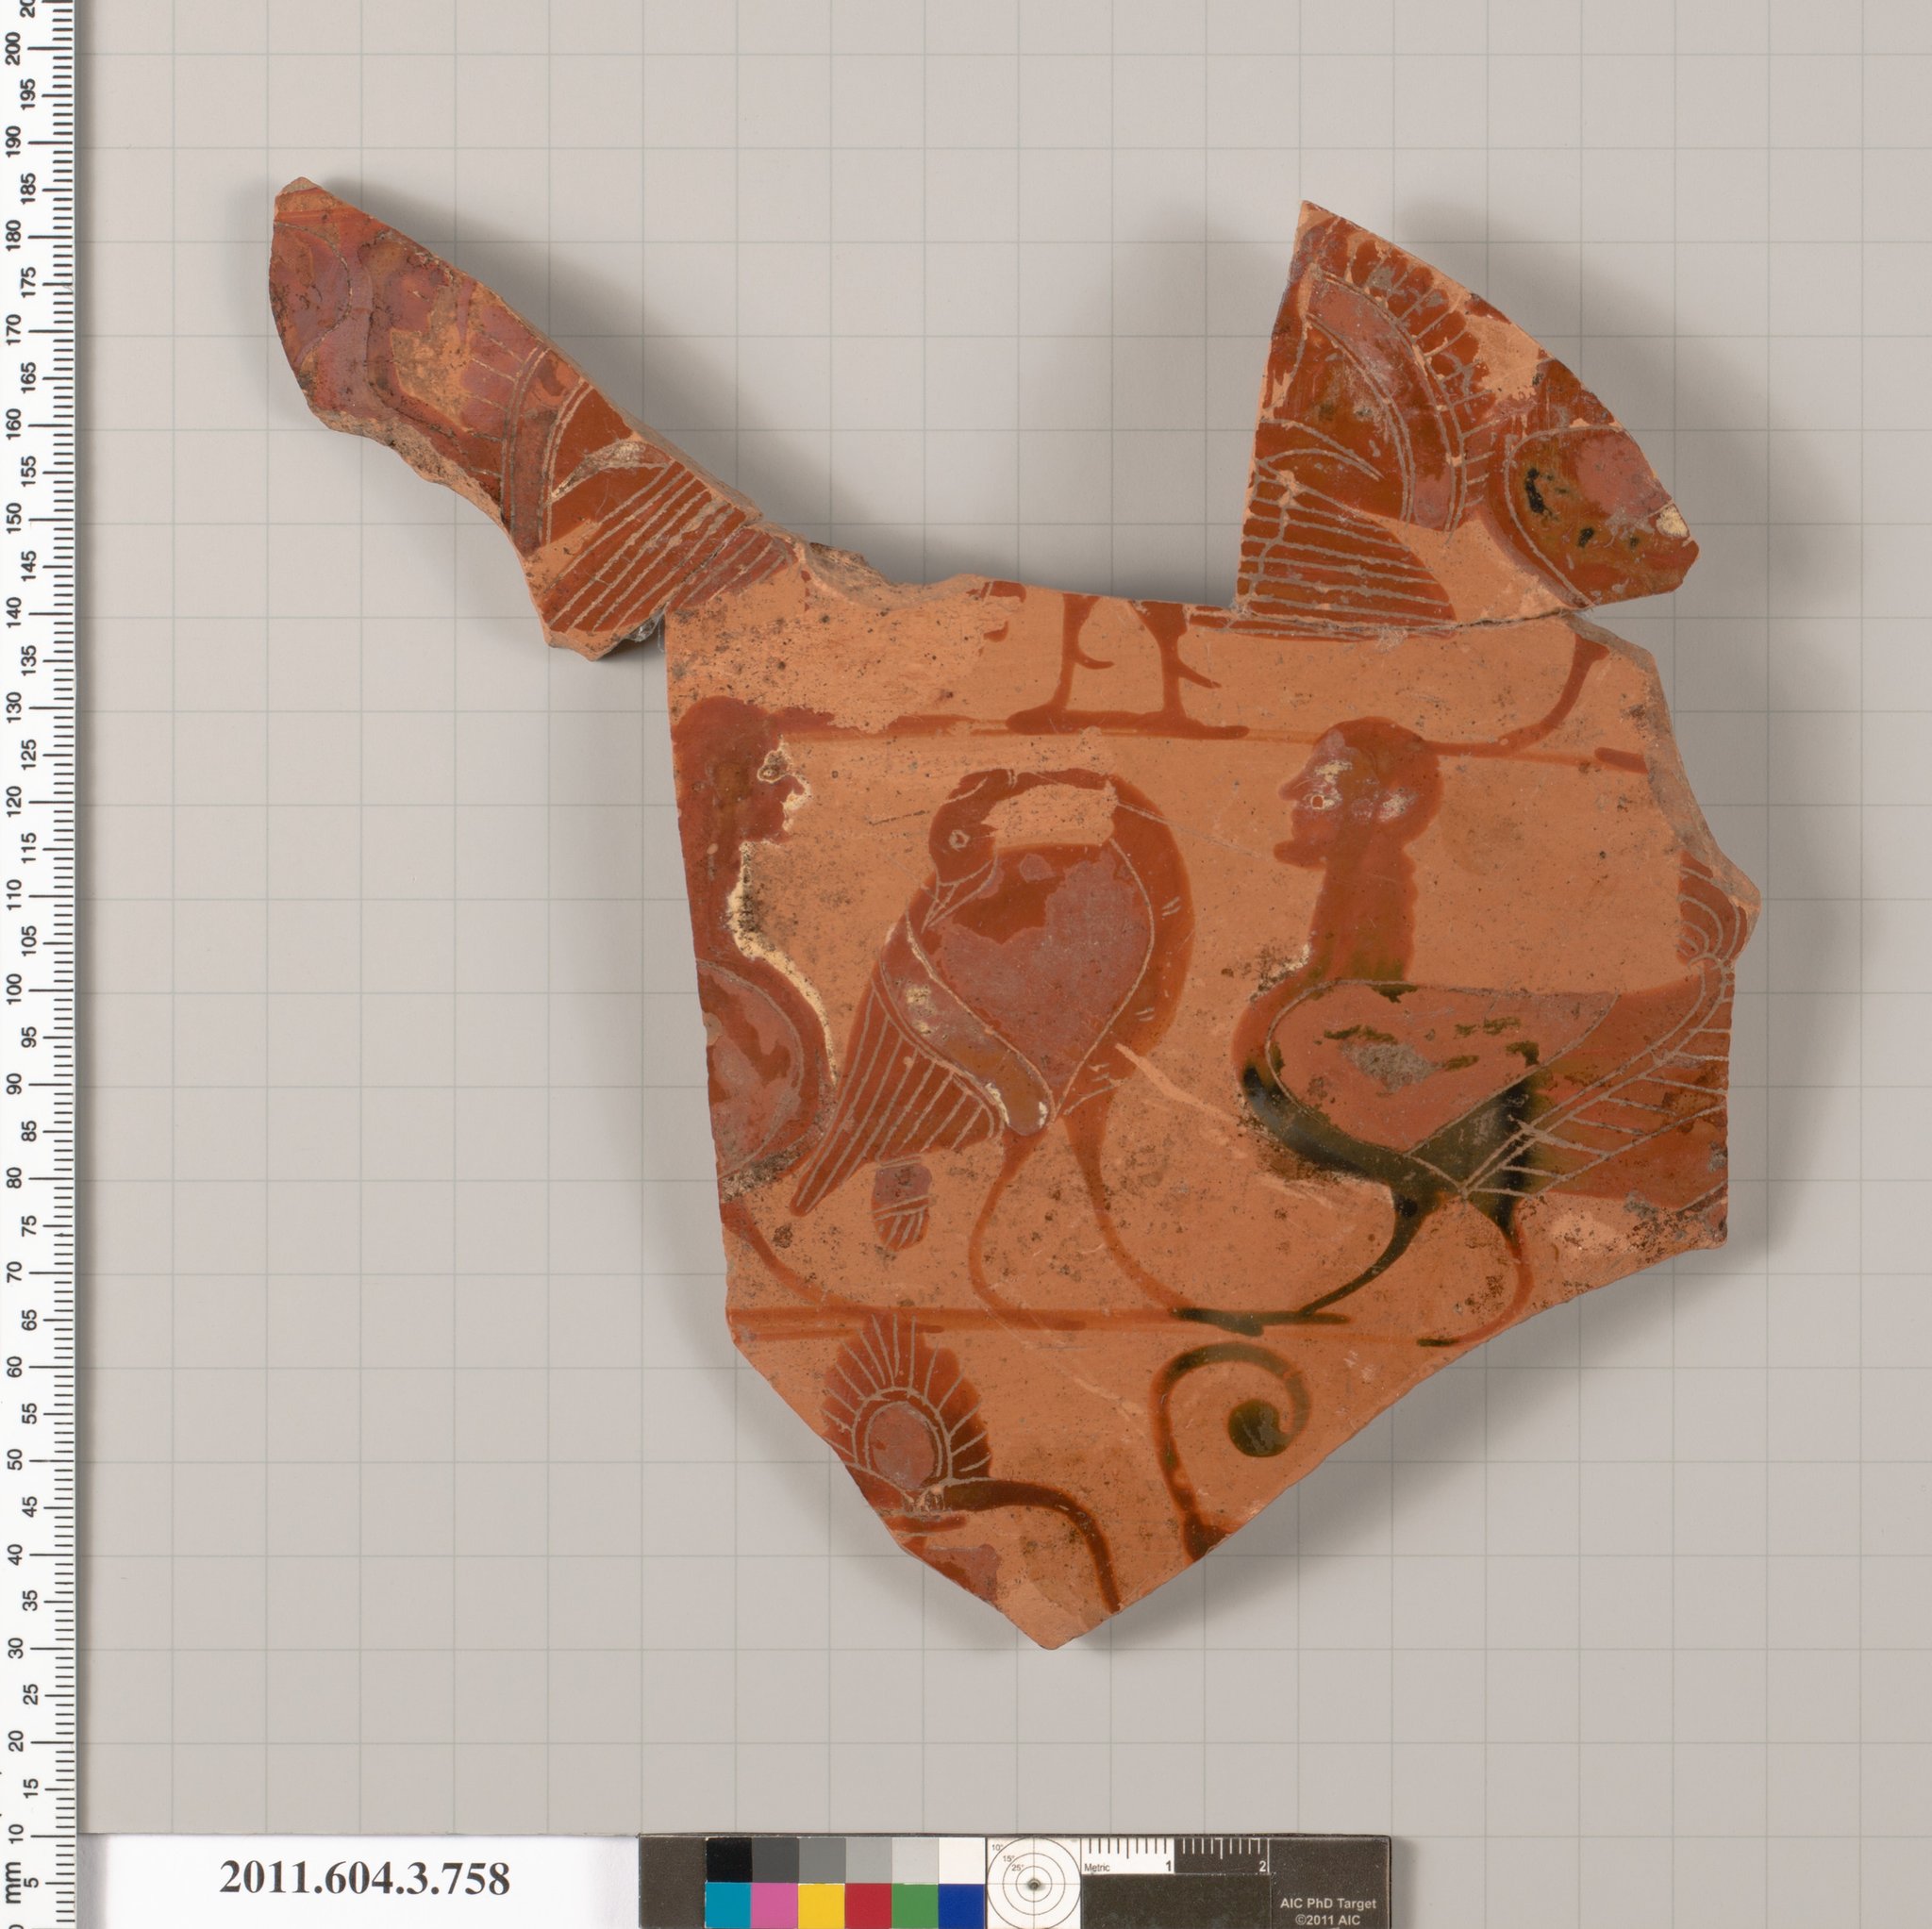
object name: neck amphora, tyrrhenian fragment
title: Terracotta fragment of a neck-amphora (jar)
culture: greek, attic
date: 575-551 BCE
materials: terracotta